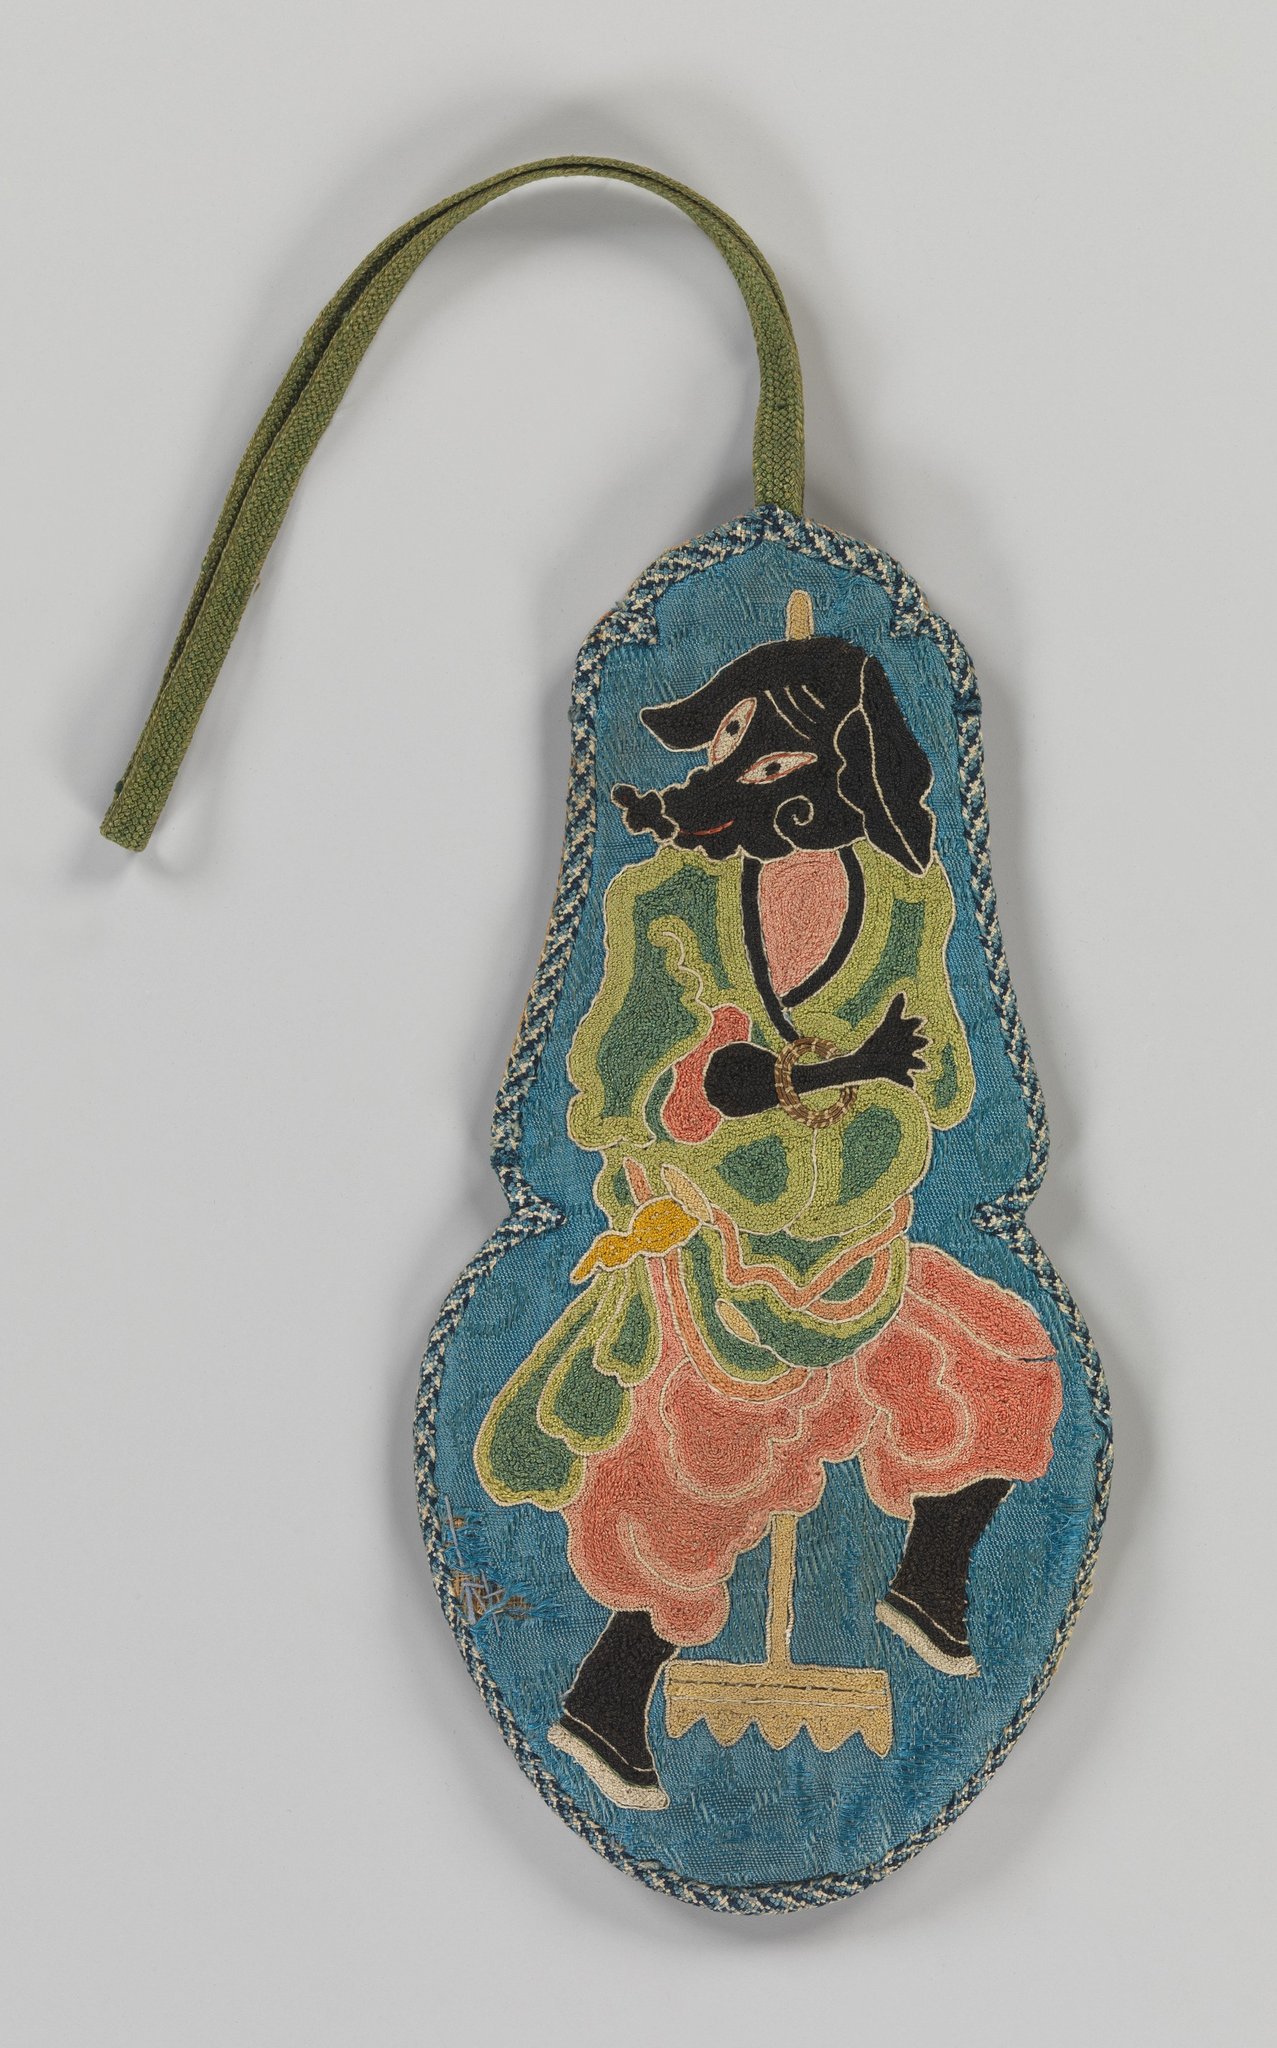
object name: bag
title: Gourd-Shaped Case with Pattern of Pig-Faced Creature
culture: chinese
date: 1701-1900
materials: metal thread, silk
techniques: damask, embroidery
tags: mythical creatures